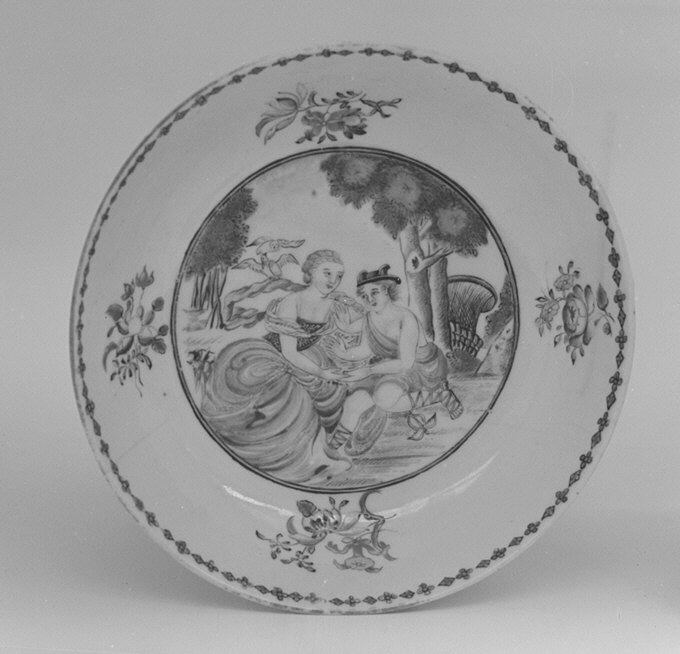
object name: saucer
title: Saucer (part of a service)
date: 1750-1770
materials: hard paste porcelain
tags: birds,women,flowers